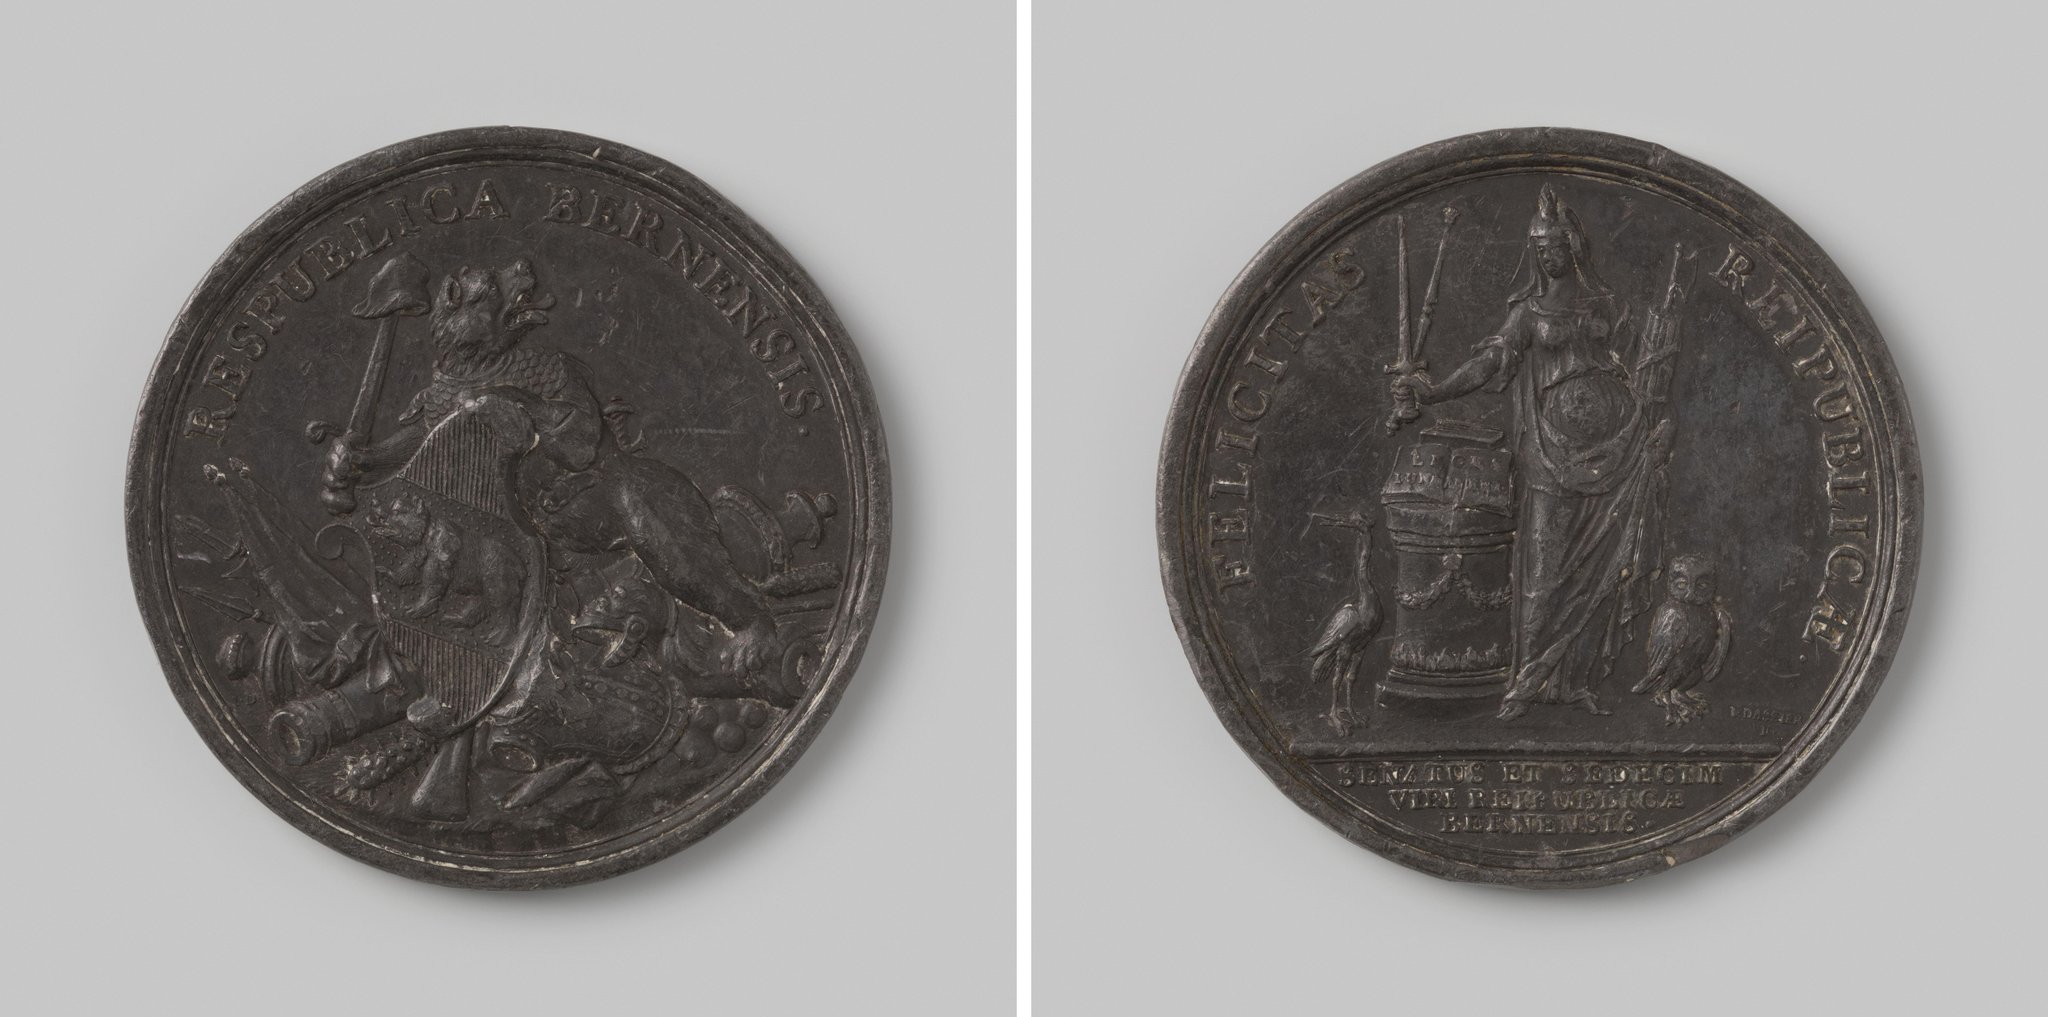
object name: history medal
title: Herdenking van de oprichting van de stad Bern (ca 1742)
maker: jean dassier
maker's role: medailleur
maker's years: 1676-1763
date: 1745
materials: tin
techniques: striking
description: Tinnen penning, op de voorzijde een omziende beer naar links met zwaard en wapenschild te midden van militaire attributen, met omschrift, op de keerzijde een vrouwelijke genius met zwaard, scepter en fasces, staand naast een altaar met een wetboek, tussen een ooievaar en een uil, met omschrift en afsnedetekst.